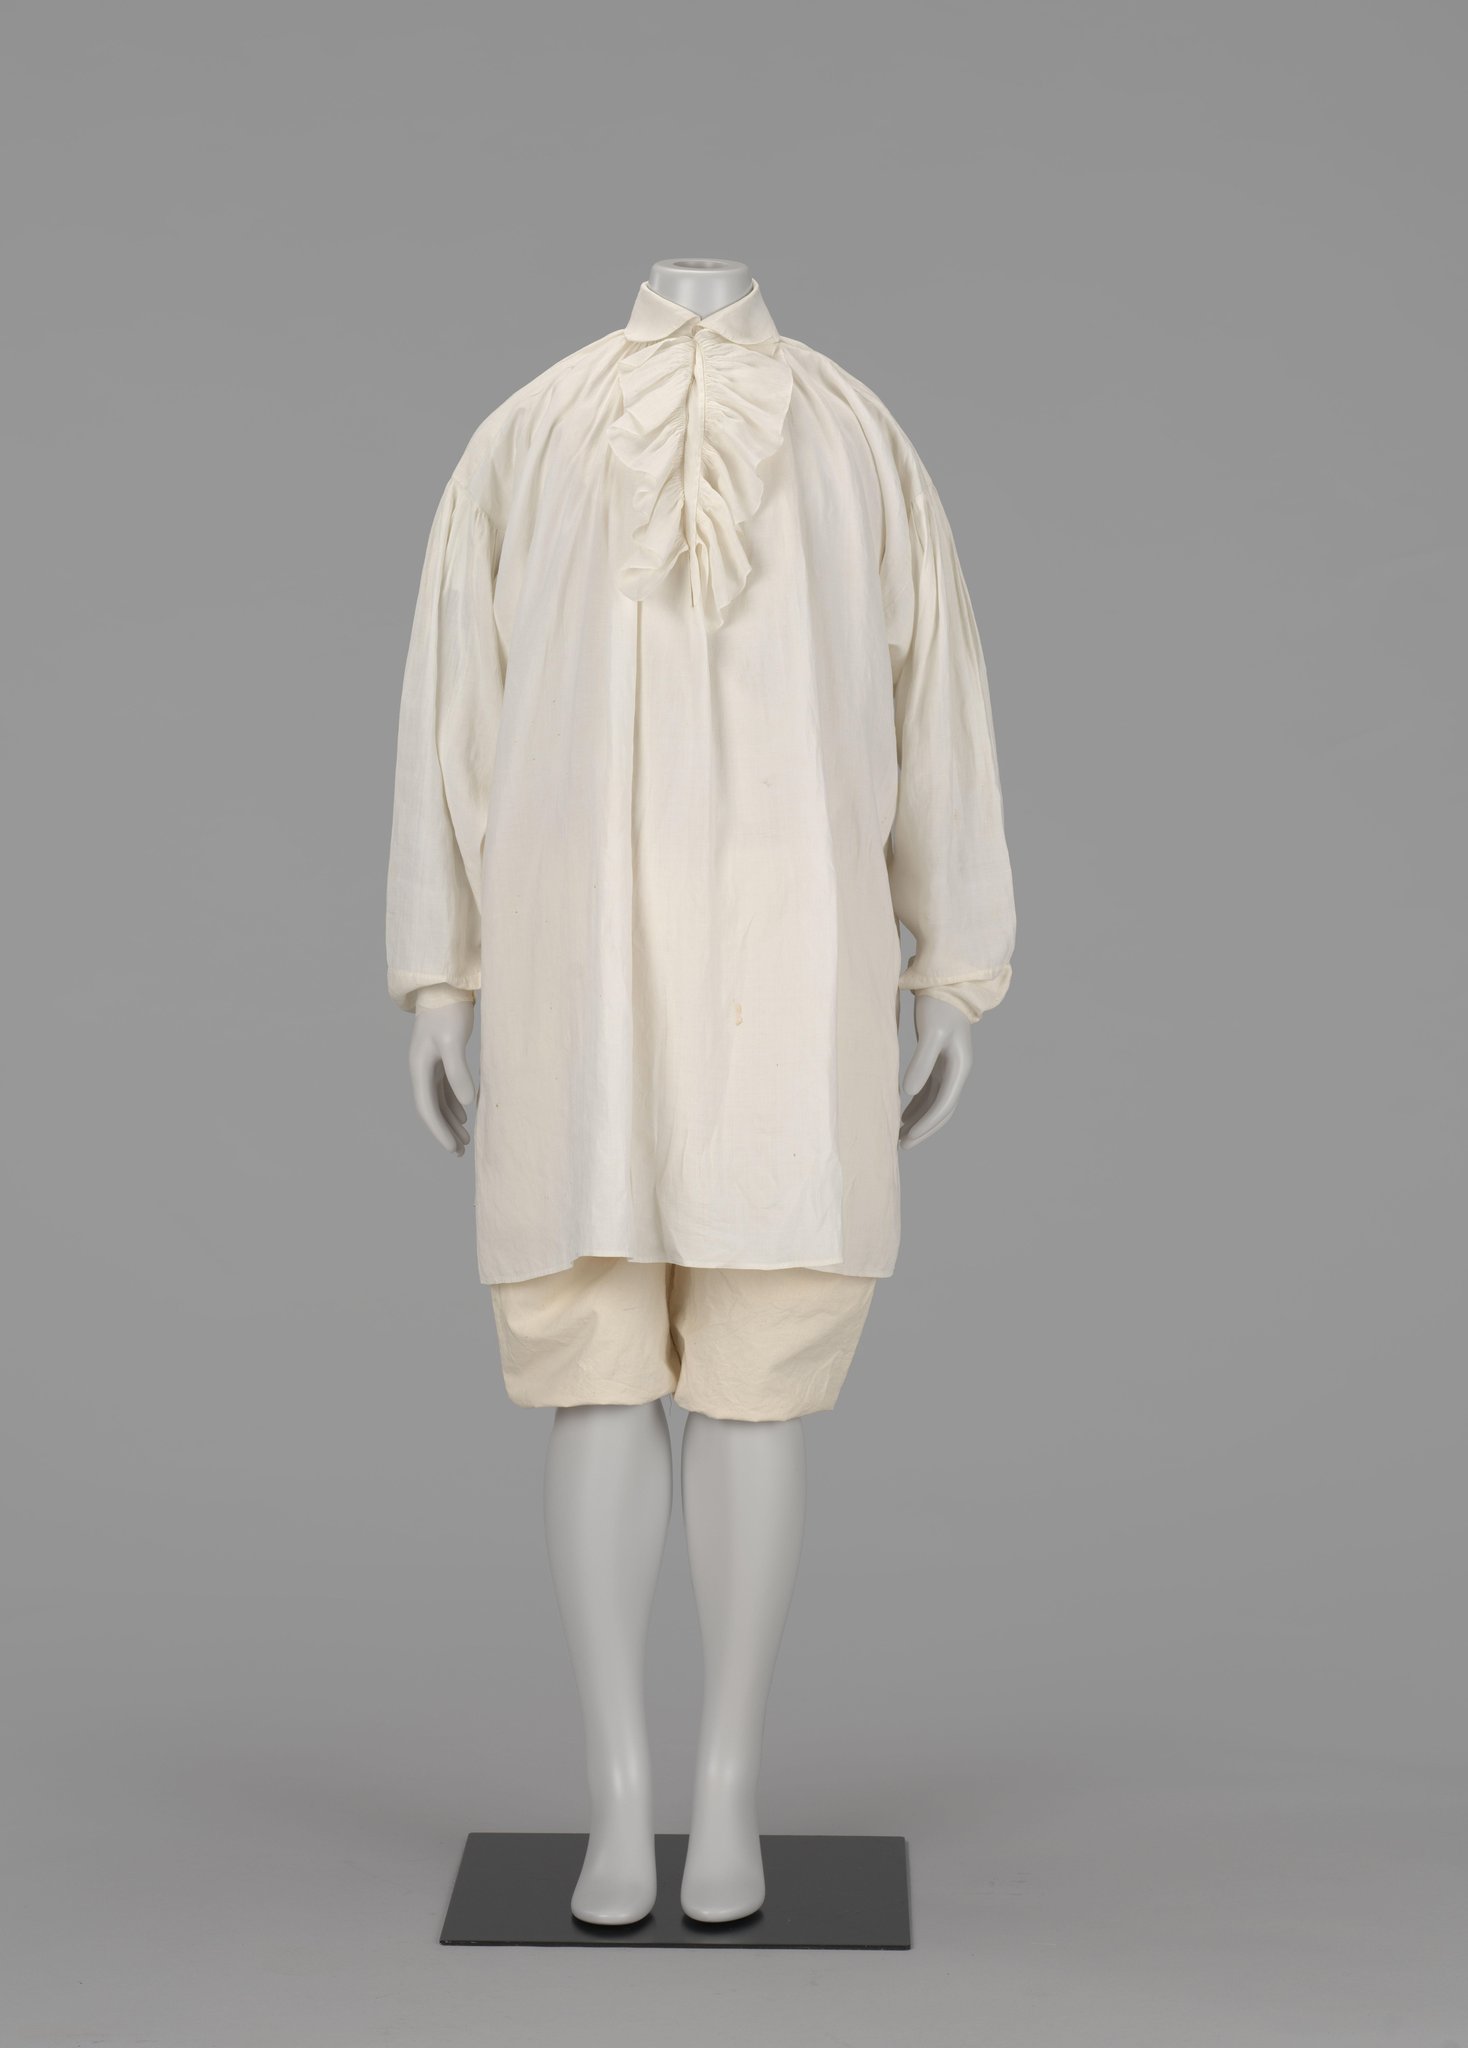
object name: underwear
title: Herenhemd van linnen met lange mouwen met manchetten en split met jabot.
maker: Anonymous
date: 1740-1770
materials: linen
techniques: weave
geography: netherlands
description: Herenhemd van linnen met lange mouwen met manchetten en split met jabot. Het halssplit heeft een jabot en eindigt in een driehoekje van naaldlkantsteekjes. De jabot van fijner linnen is gerimpeld aan een grof linnen bandje gezet, waardoor hij snel is uit te tornen en in te zetten. Onder het boord, dat sluit met een geborduurd knoopje en liggend knoopsgat, is de stof zeer ruim gerimpeld aangezet en met twee schouderbelegstukken en een driehoekig inzetstukje bij de hals versterkt. De lange mouw is ruim geplooid bij de schouder en glad bij de pols aangezet en heeft een manchet van fijner linnen. Het armsgat is zeer wijd en vertoond weer een ingezet driehoekje aan de onderzijde. De twee zijsplitten, van de zelfkant, zijn met een trensje versterkt (vermoedelijk hersteld).